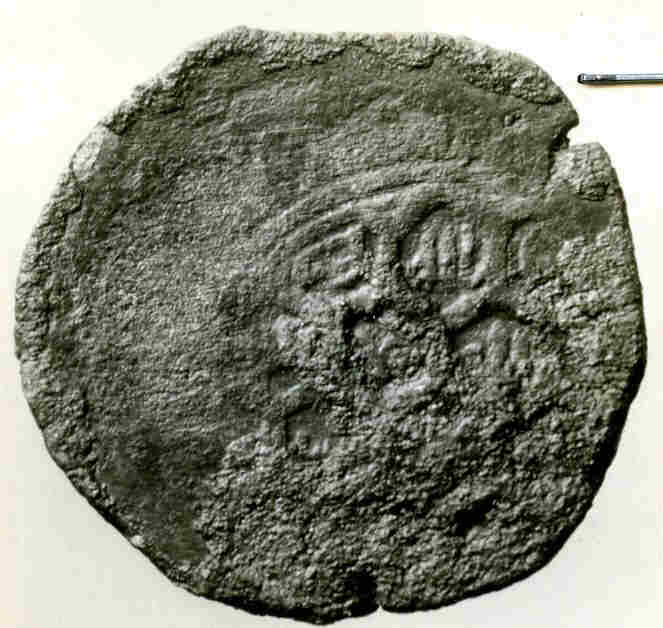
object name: coin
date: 1267-1300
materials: copper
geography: iran